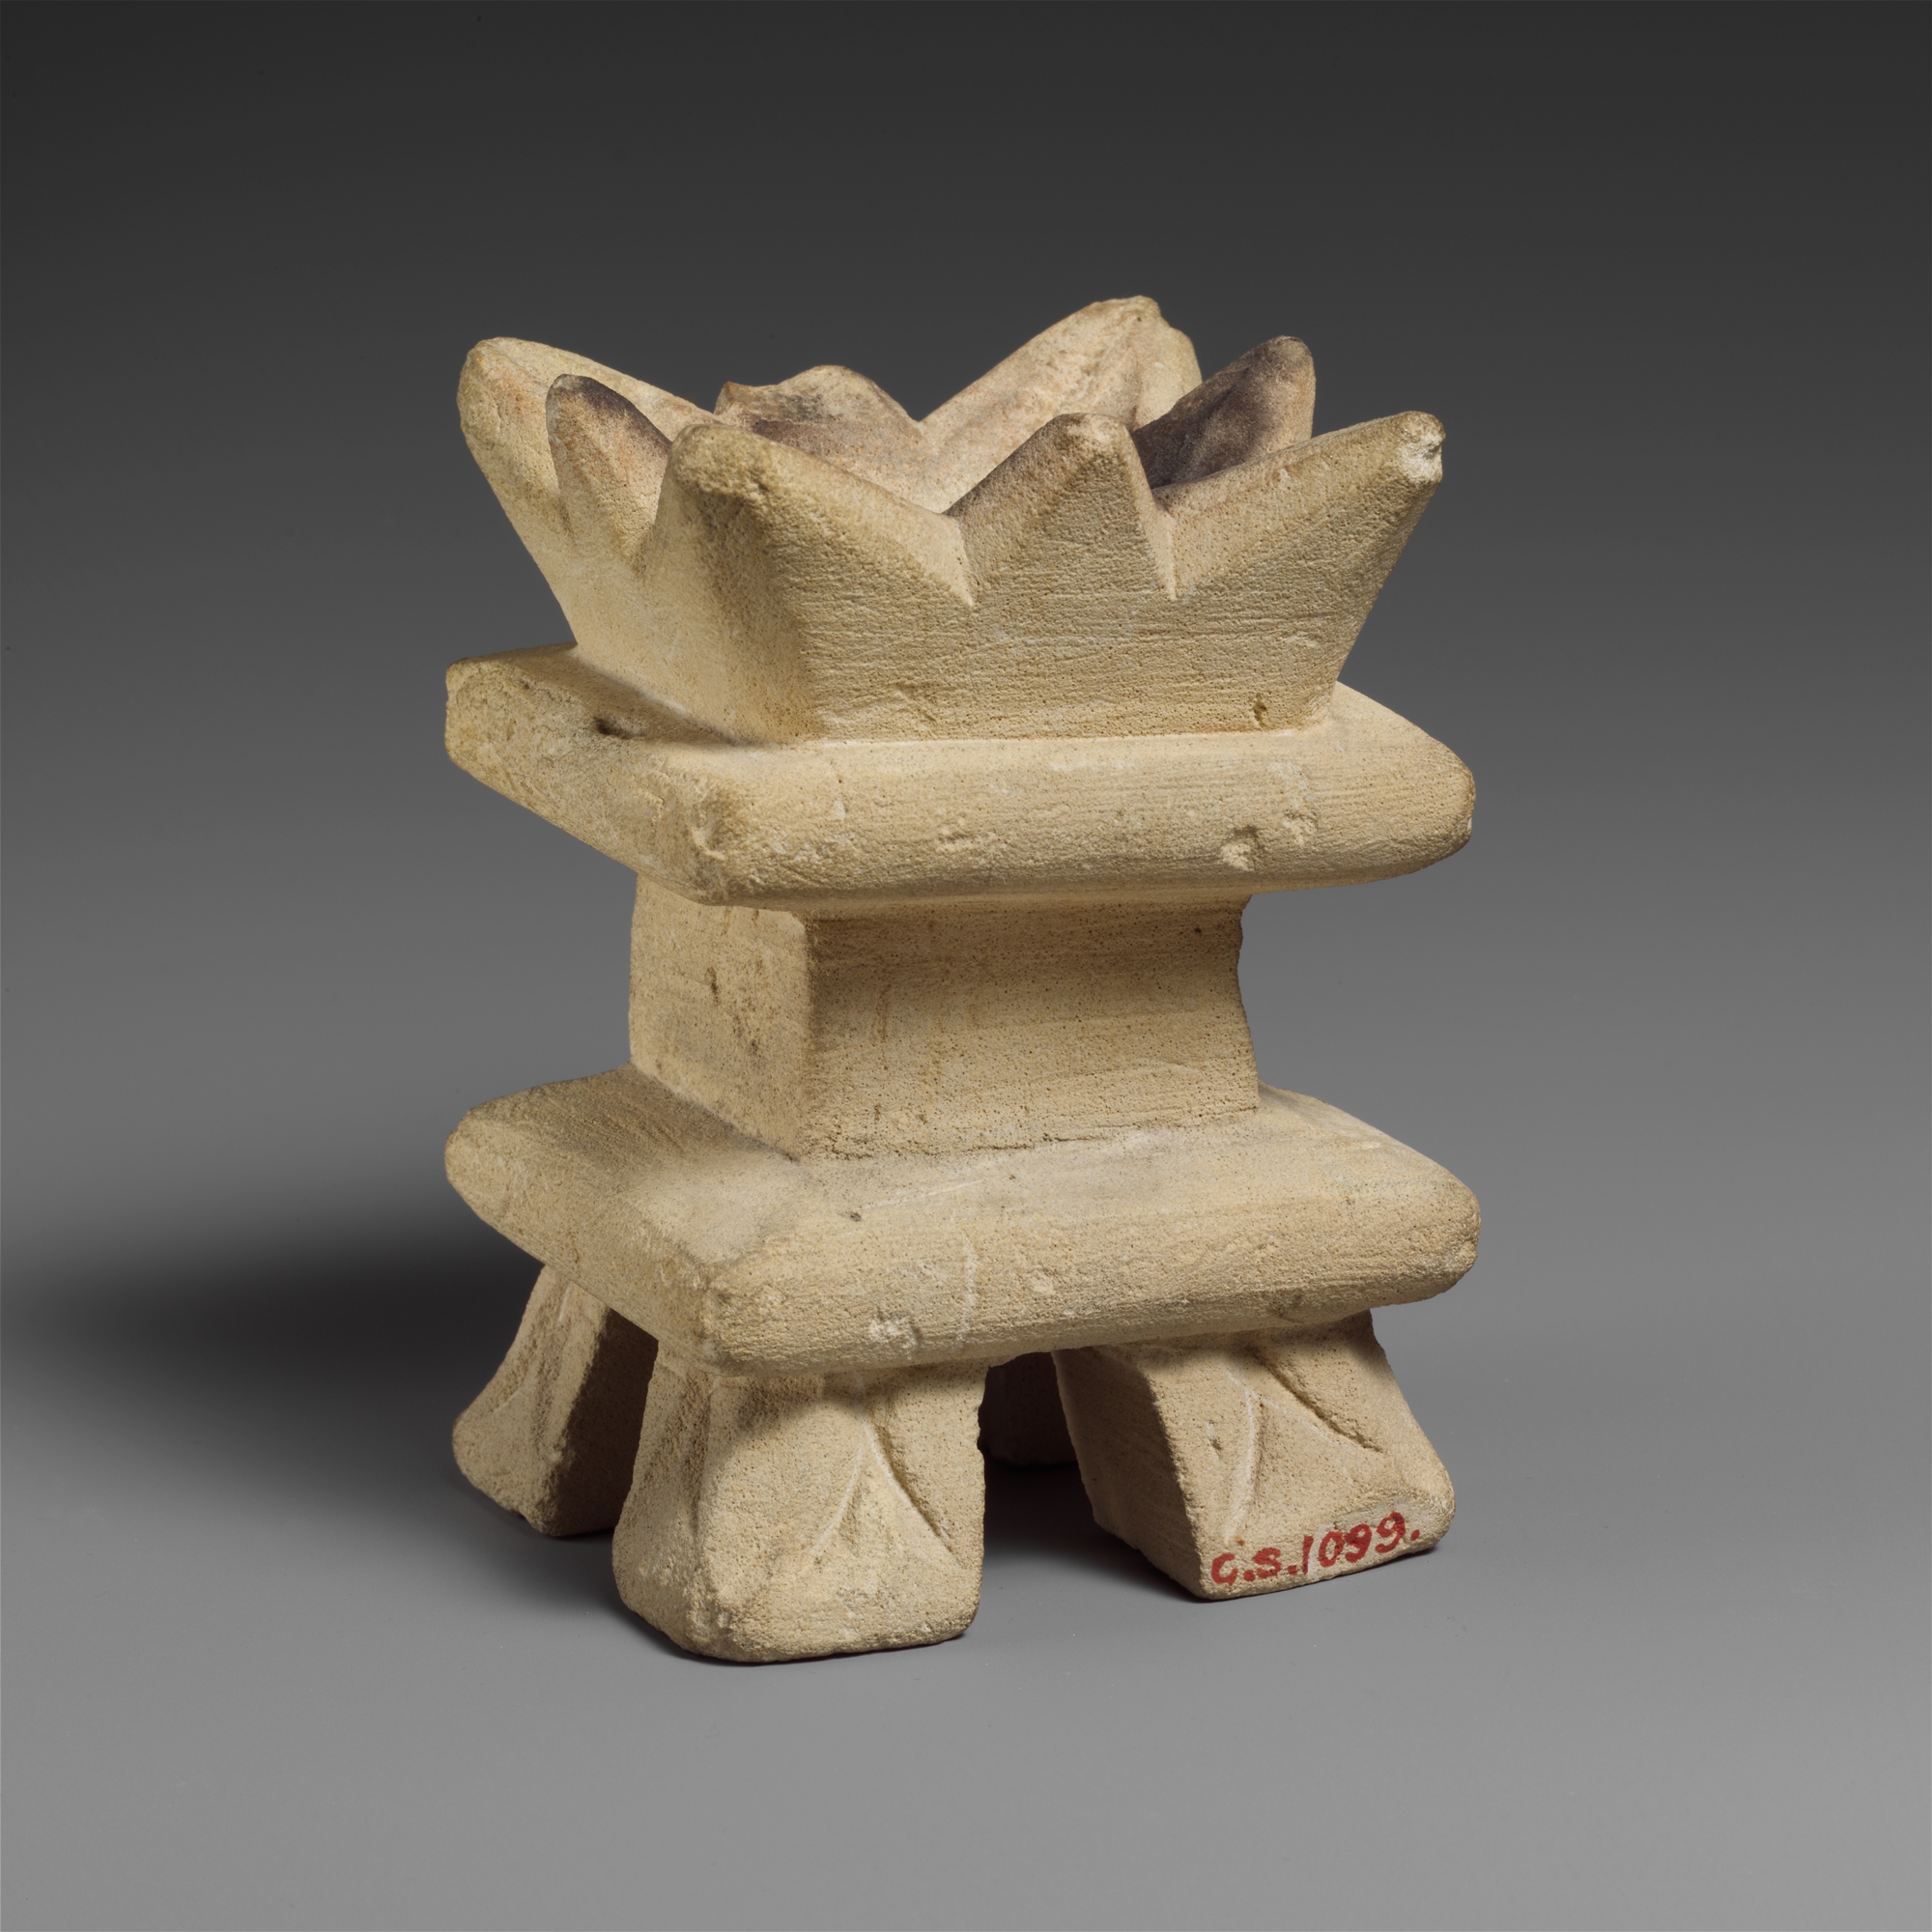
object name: altar, miniature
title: Limestone incense burner on four legs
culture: cypriot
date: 600-501 BCE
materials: limestone